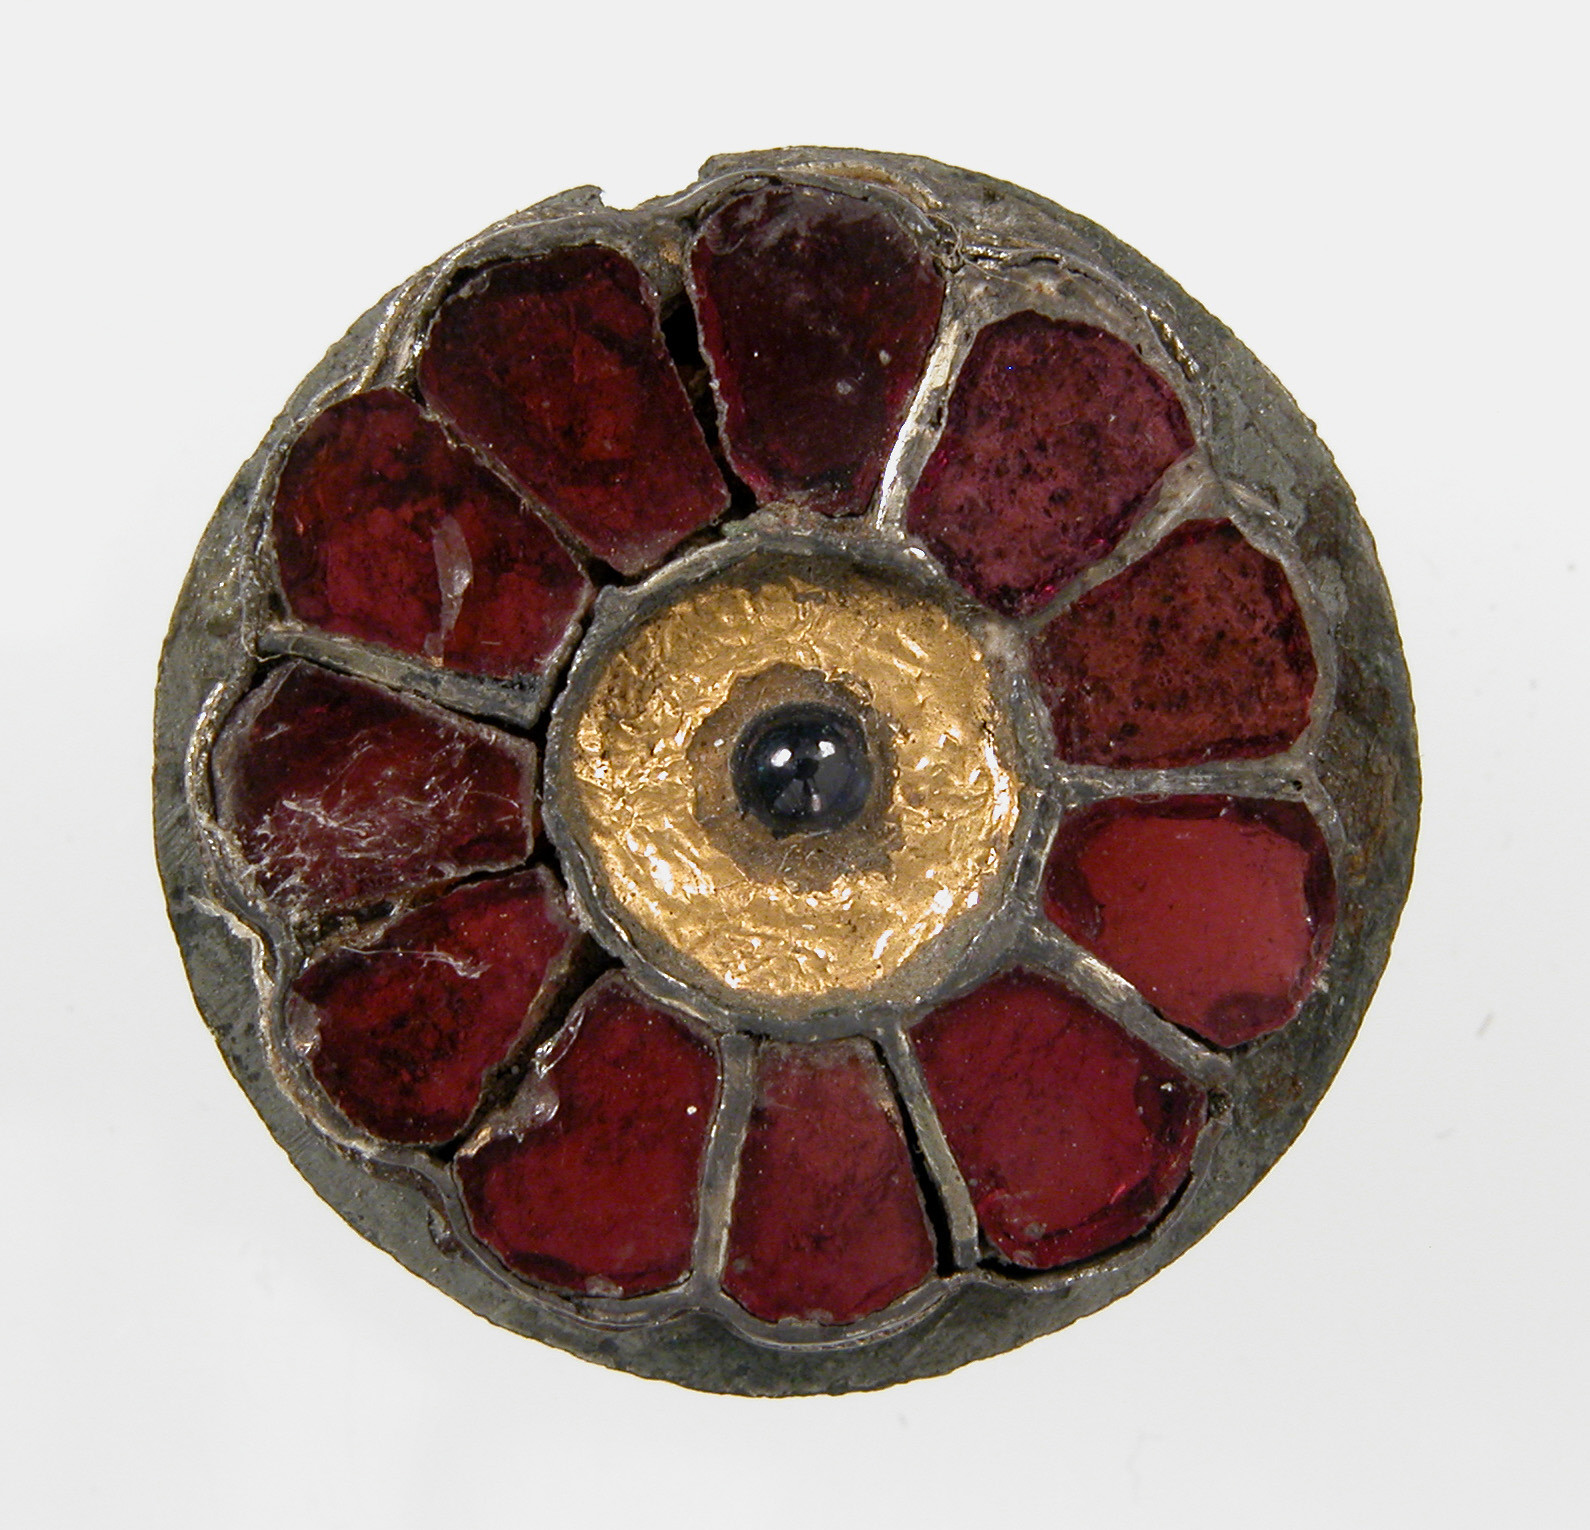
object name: brooch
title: Disk Brooch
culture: frankish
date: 550-650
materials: copper alloy, foil, gemstone, gilt, silver